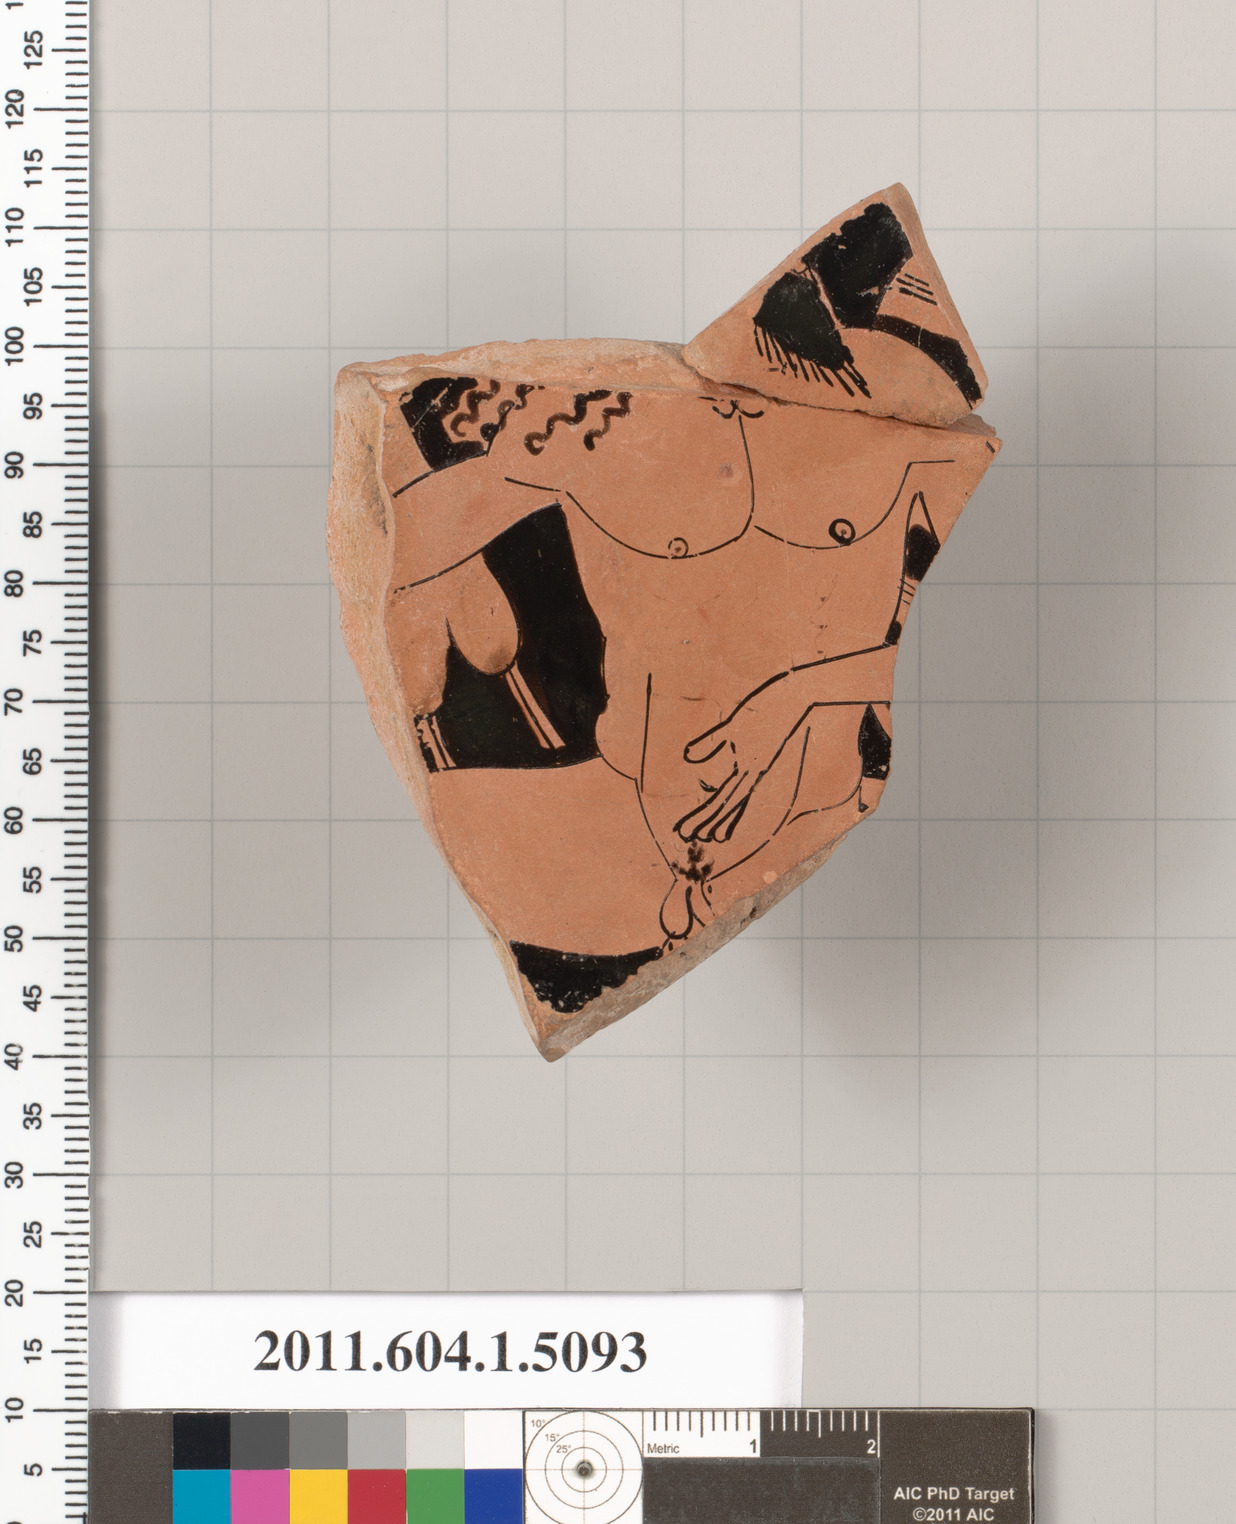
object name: kylix fragment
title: Terracotta fragment of a kylix (drinking cup)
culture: greek, attic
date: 500-480 BCE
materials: terracotta